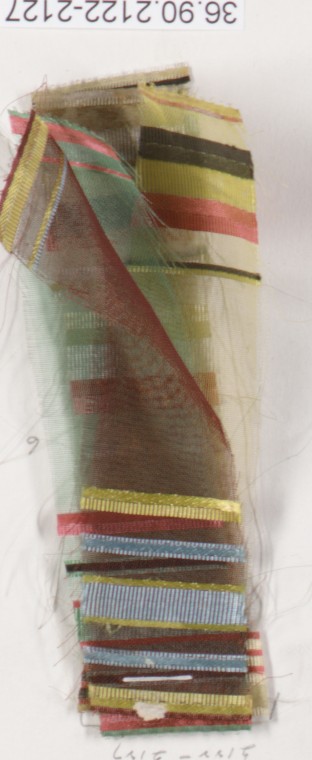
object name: piece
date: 1801-1900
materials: silk